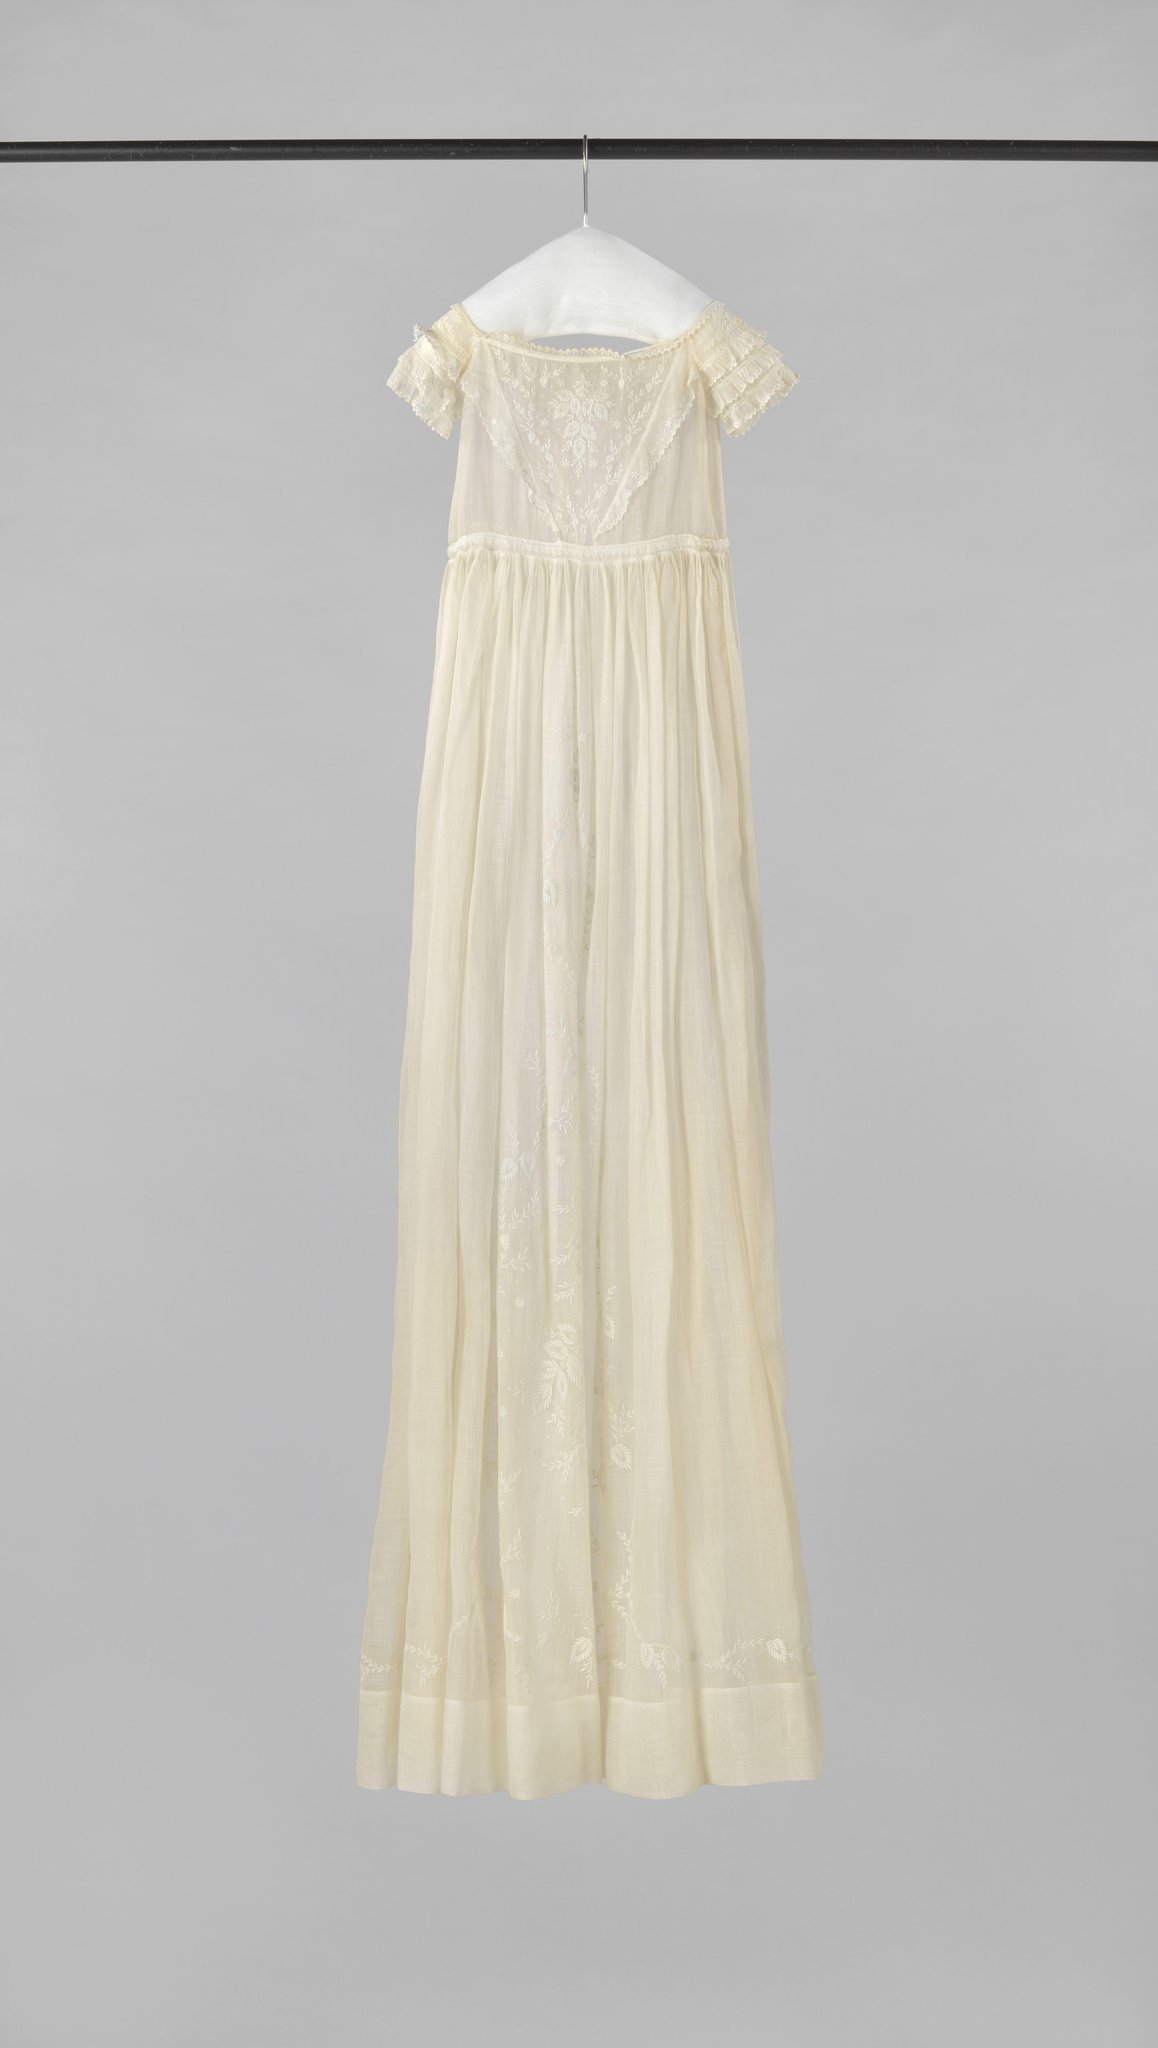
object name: doopjurk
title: Doopjurk van witte batist met borduurwerk van slingerende takken met bladwerk en losse margrieten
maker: Anonymous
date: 1860-1890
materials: textile, cotton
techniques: embroidered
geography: netherlands